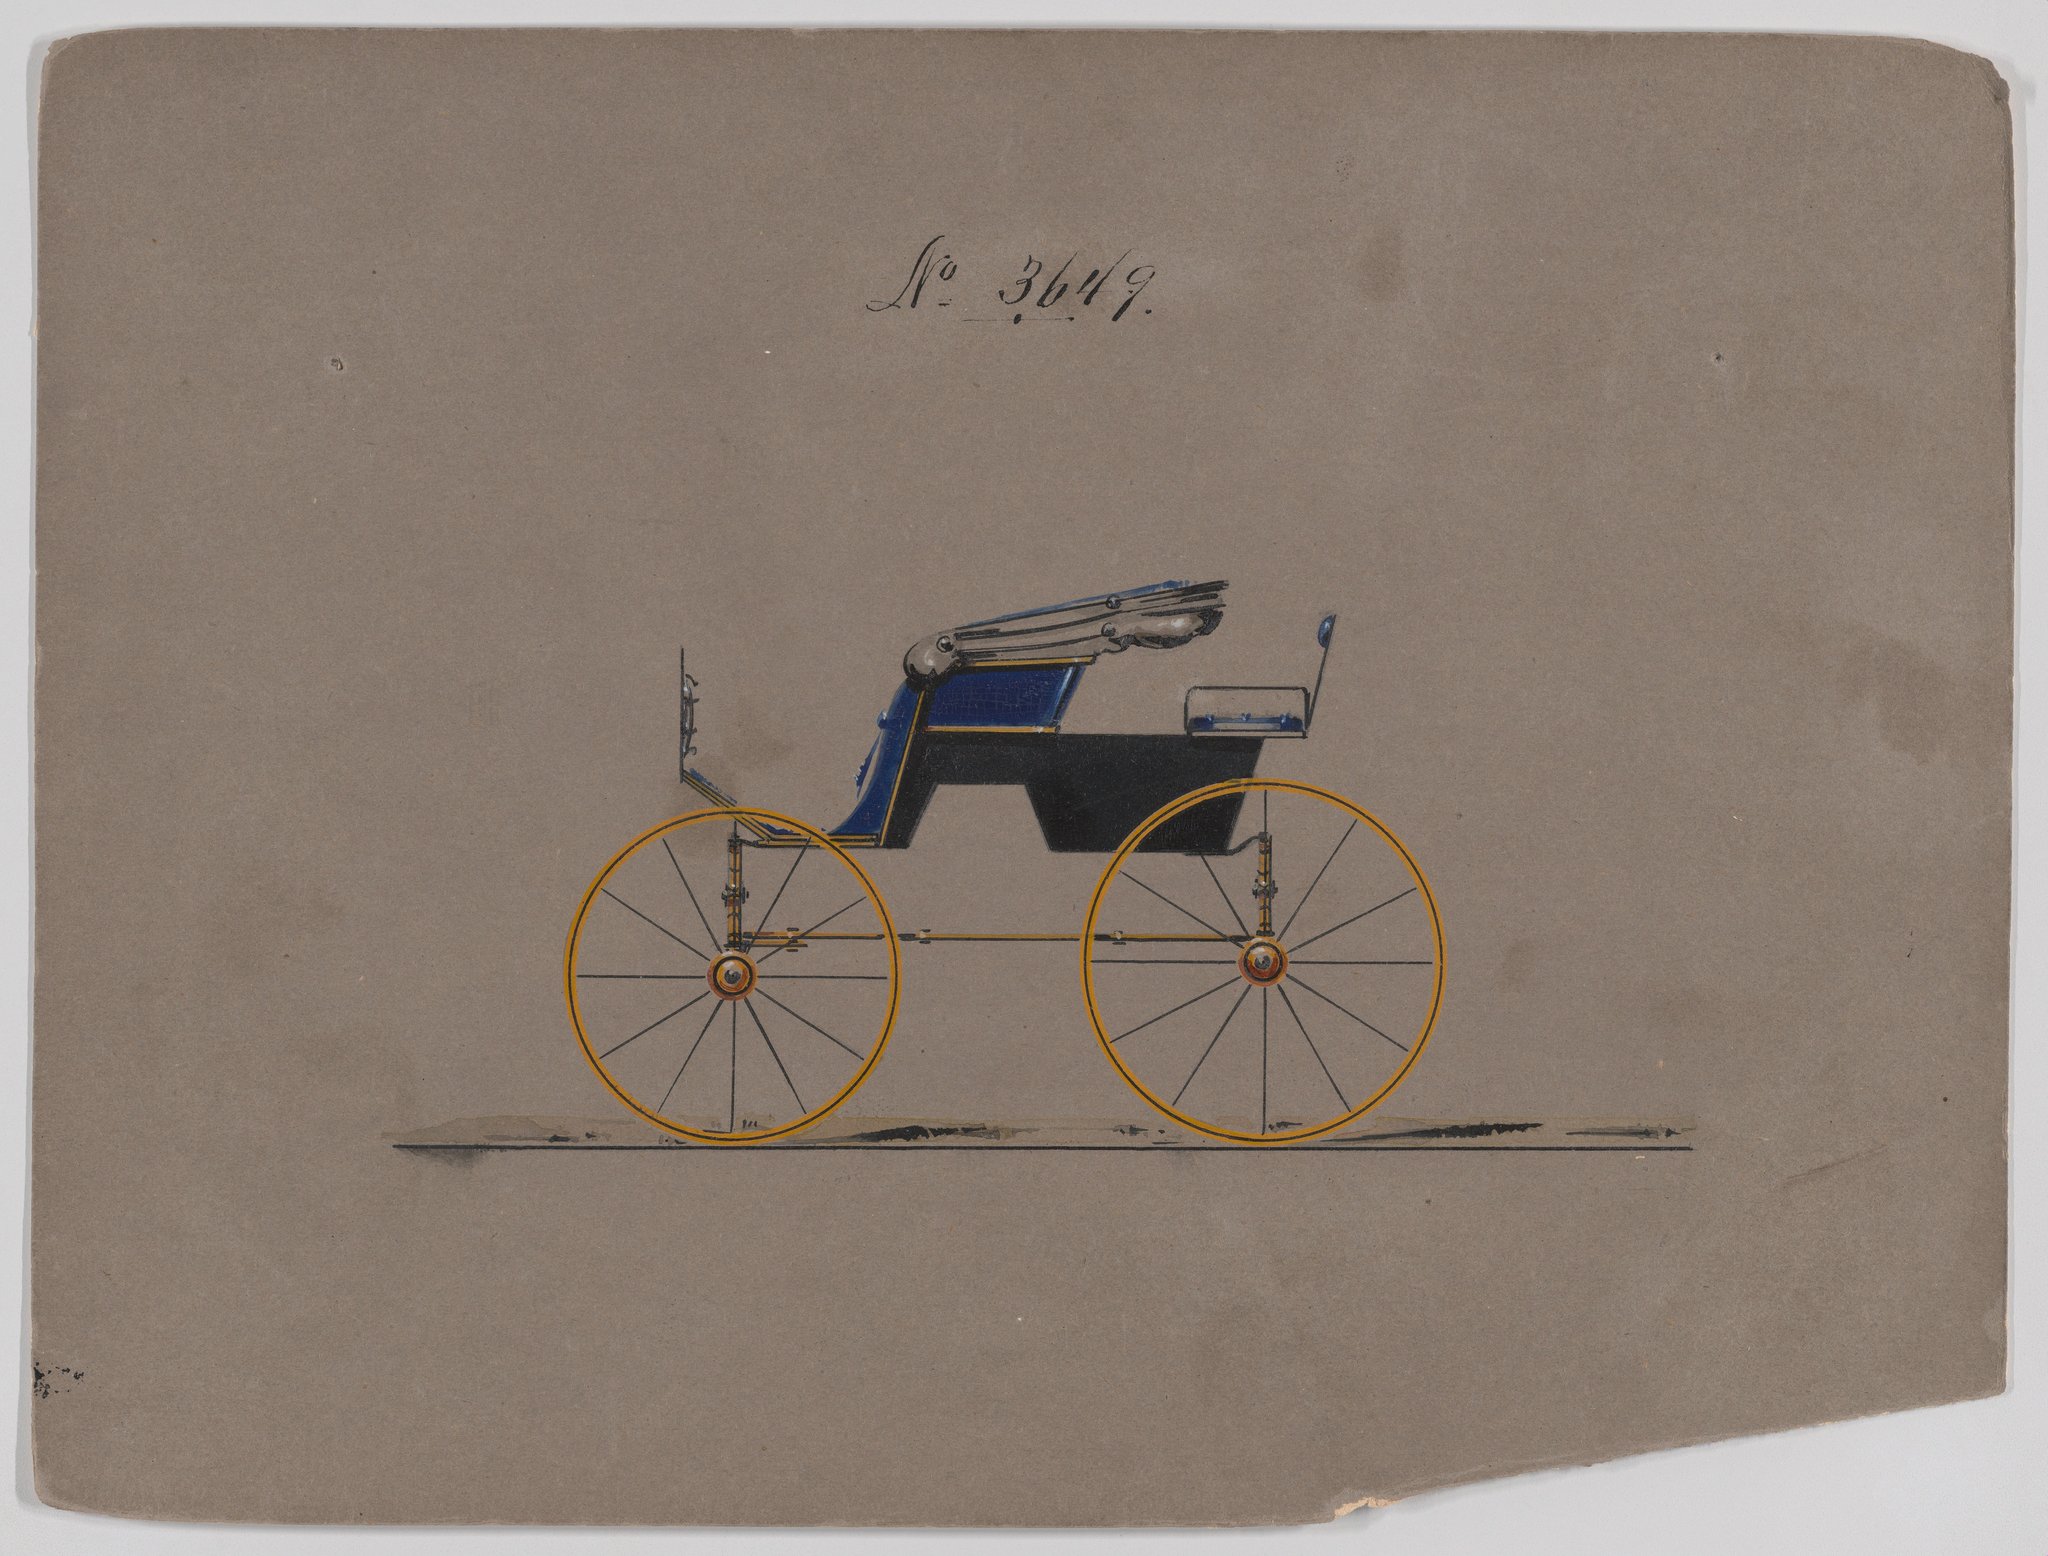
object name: drawing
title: Design for Stanhope Phaeton, no. 3649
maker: brewster & co.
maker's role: manufacturer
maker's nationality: american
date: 1881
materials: gouache, gum arabic, ink, watercolor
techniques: pen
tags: carriages